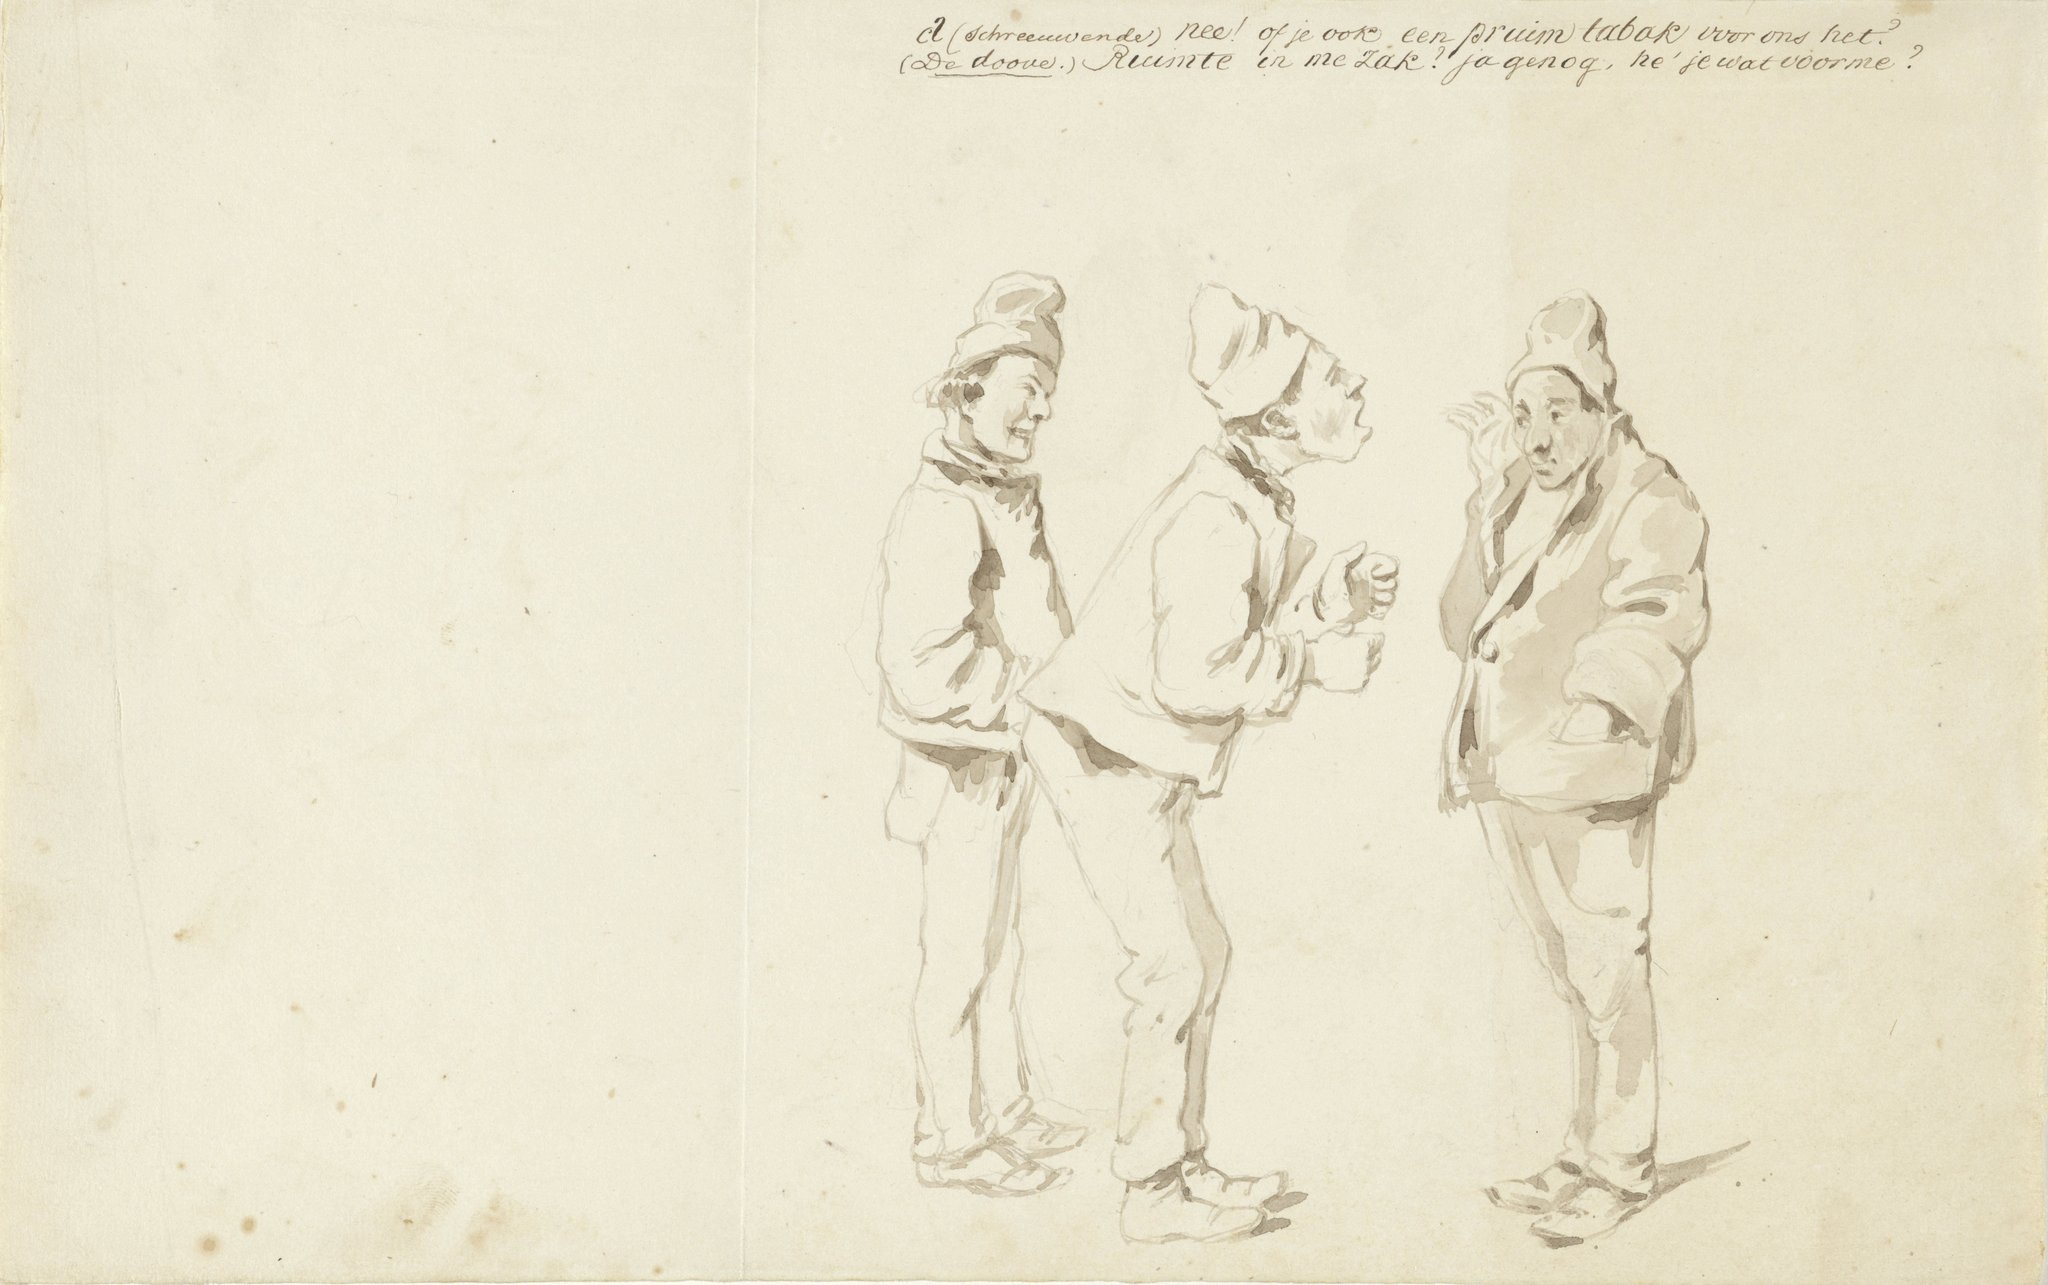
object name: drawing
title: Drie staande mannen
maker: pieter van loon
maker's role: draughtsman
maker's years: 1801-1873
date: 1811-1873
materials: paper, pencil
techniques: brush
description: Drie staande mannen met daarbij het opschrift: A (schreeuwende) nee! of je ook een pruim tabak voor ons het? (De doove) Ruimte in me zak? ja genog, he' je wat voor me?